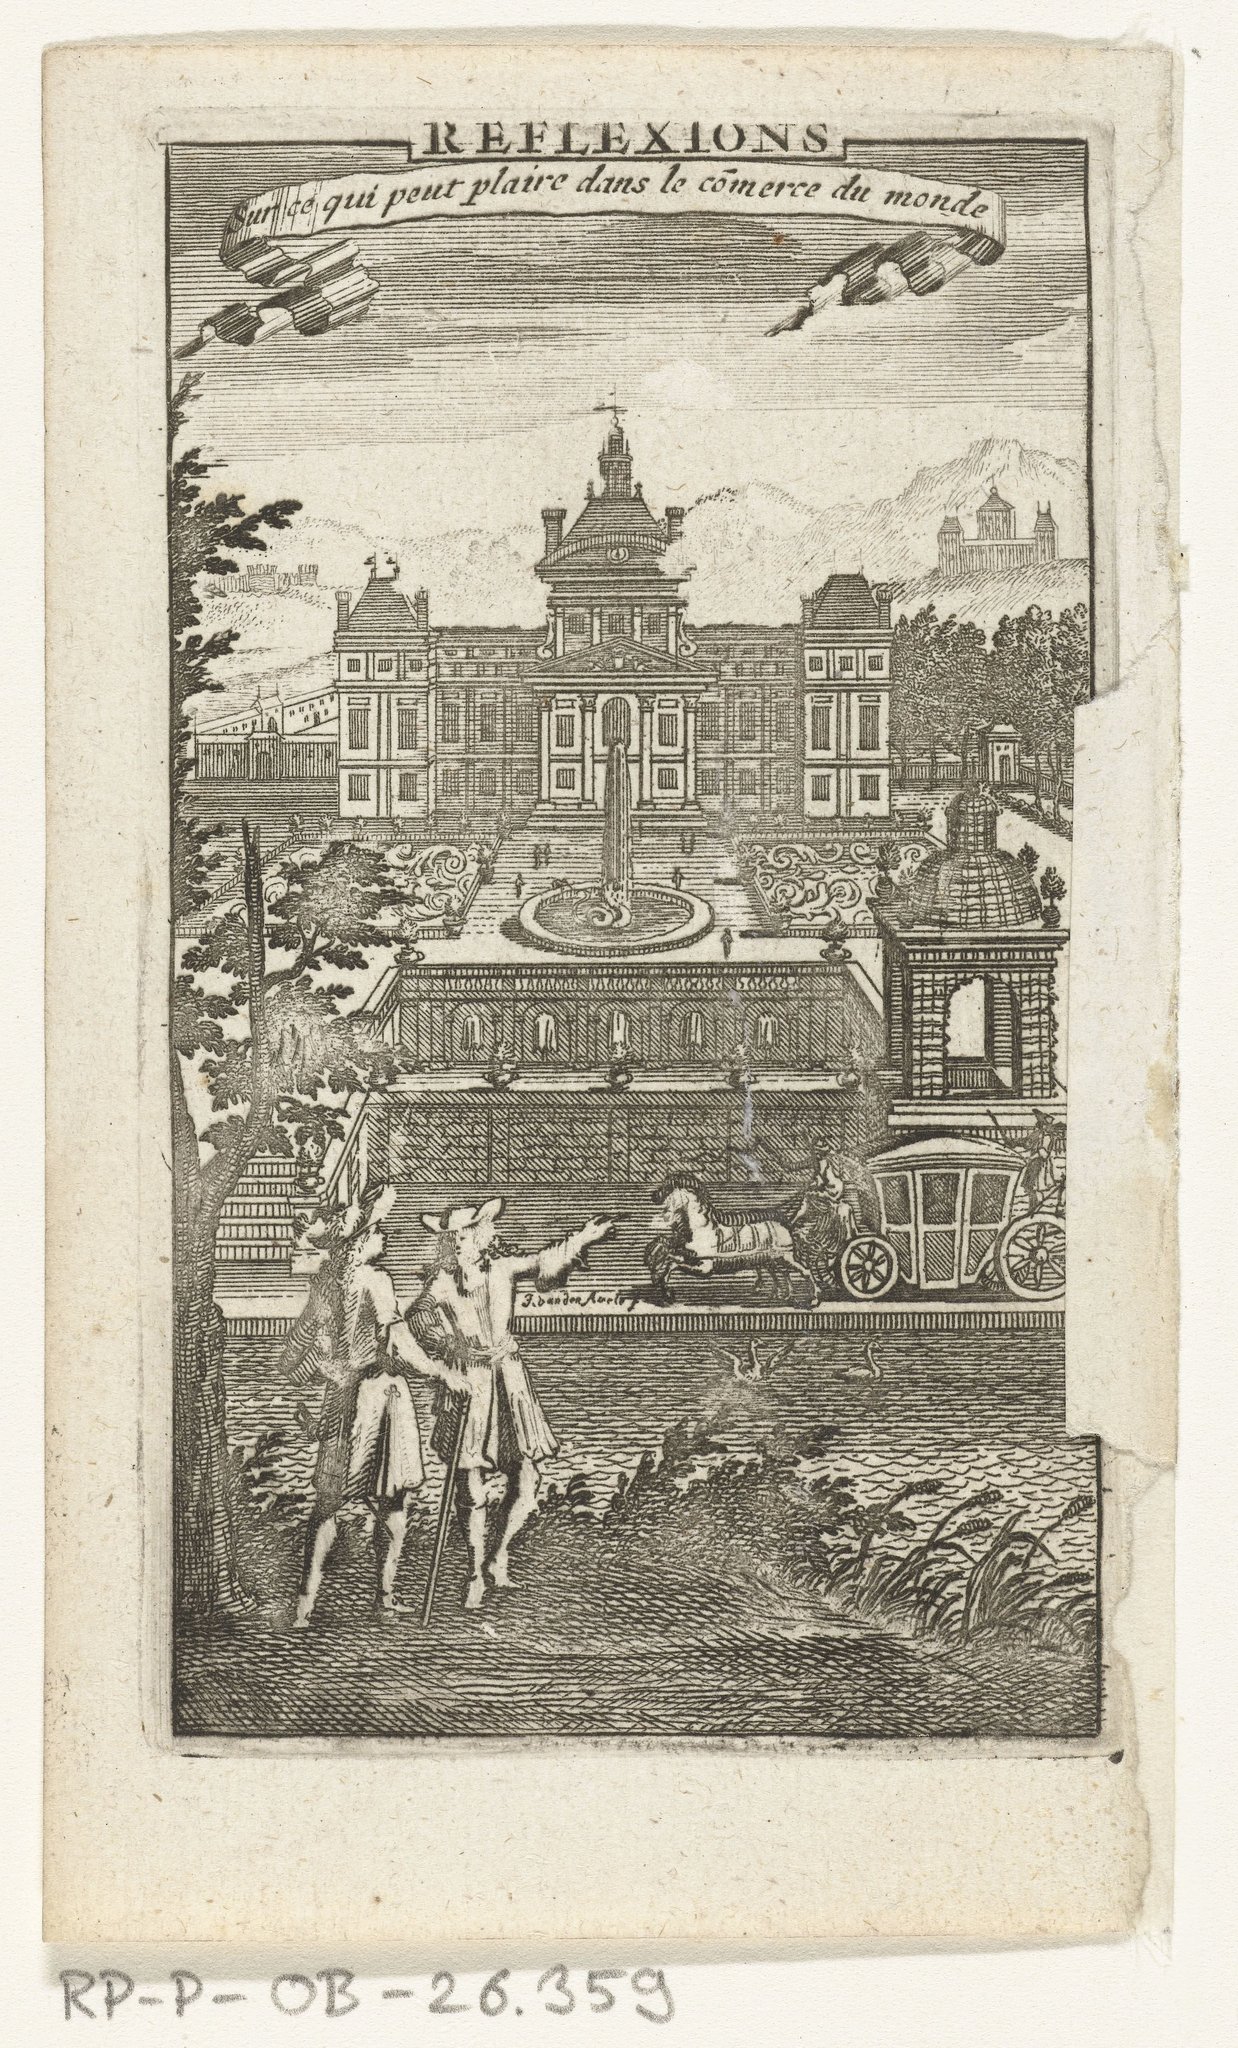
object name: print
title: Titelpagina voor Jean-Baptiste Morvan de Bellegarde, Reflexions sur ce qui peut plaire, ou déplaire dans le commerce du monde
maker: johannes jacobsz van den aveele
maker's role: print maker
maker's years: 1655-1727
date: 1690-1727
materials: paper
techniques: etching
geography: netherlands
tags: palace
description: titelpagina van: Jean-Baptiste Morvan de Bellegarde, Reflexions sur ce qui peut plaire, ou déplaire dans le commerce du monde, gebruikt voor meerdere edities, bijvoorbeeld Amsterdam, A. Wolfgang, 1691 en La Haye, G. de Voys, 1720